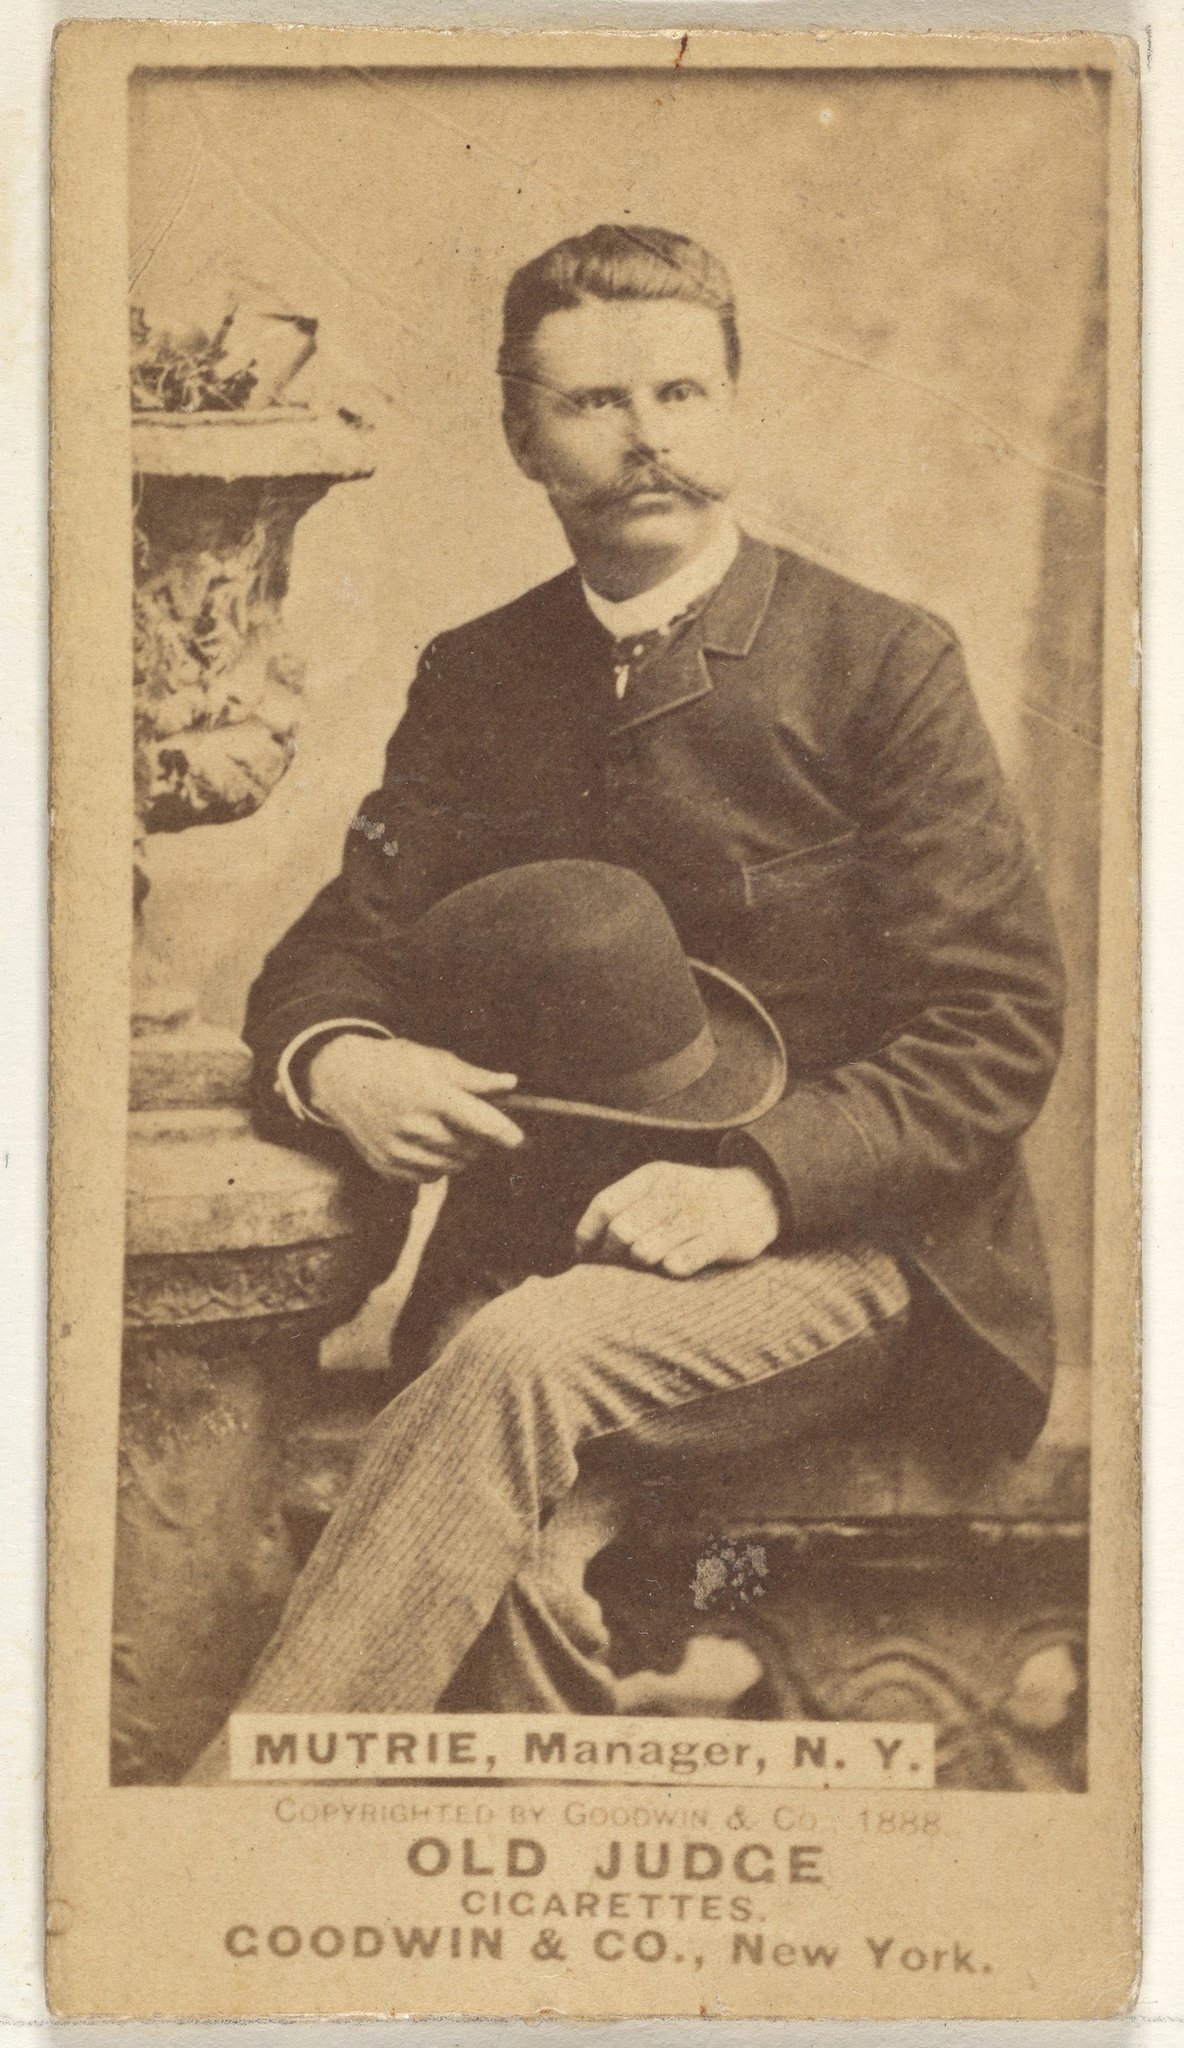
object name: baseball card, photograph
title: James J. Mutrie, Manager, New York, from the Old Judge series (N172) for Old Judge Cigarettes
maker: goodwin & company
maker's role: publisher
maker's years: 1850-1950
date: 1888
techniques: albumen silver print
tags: men,portraits